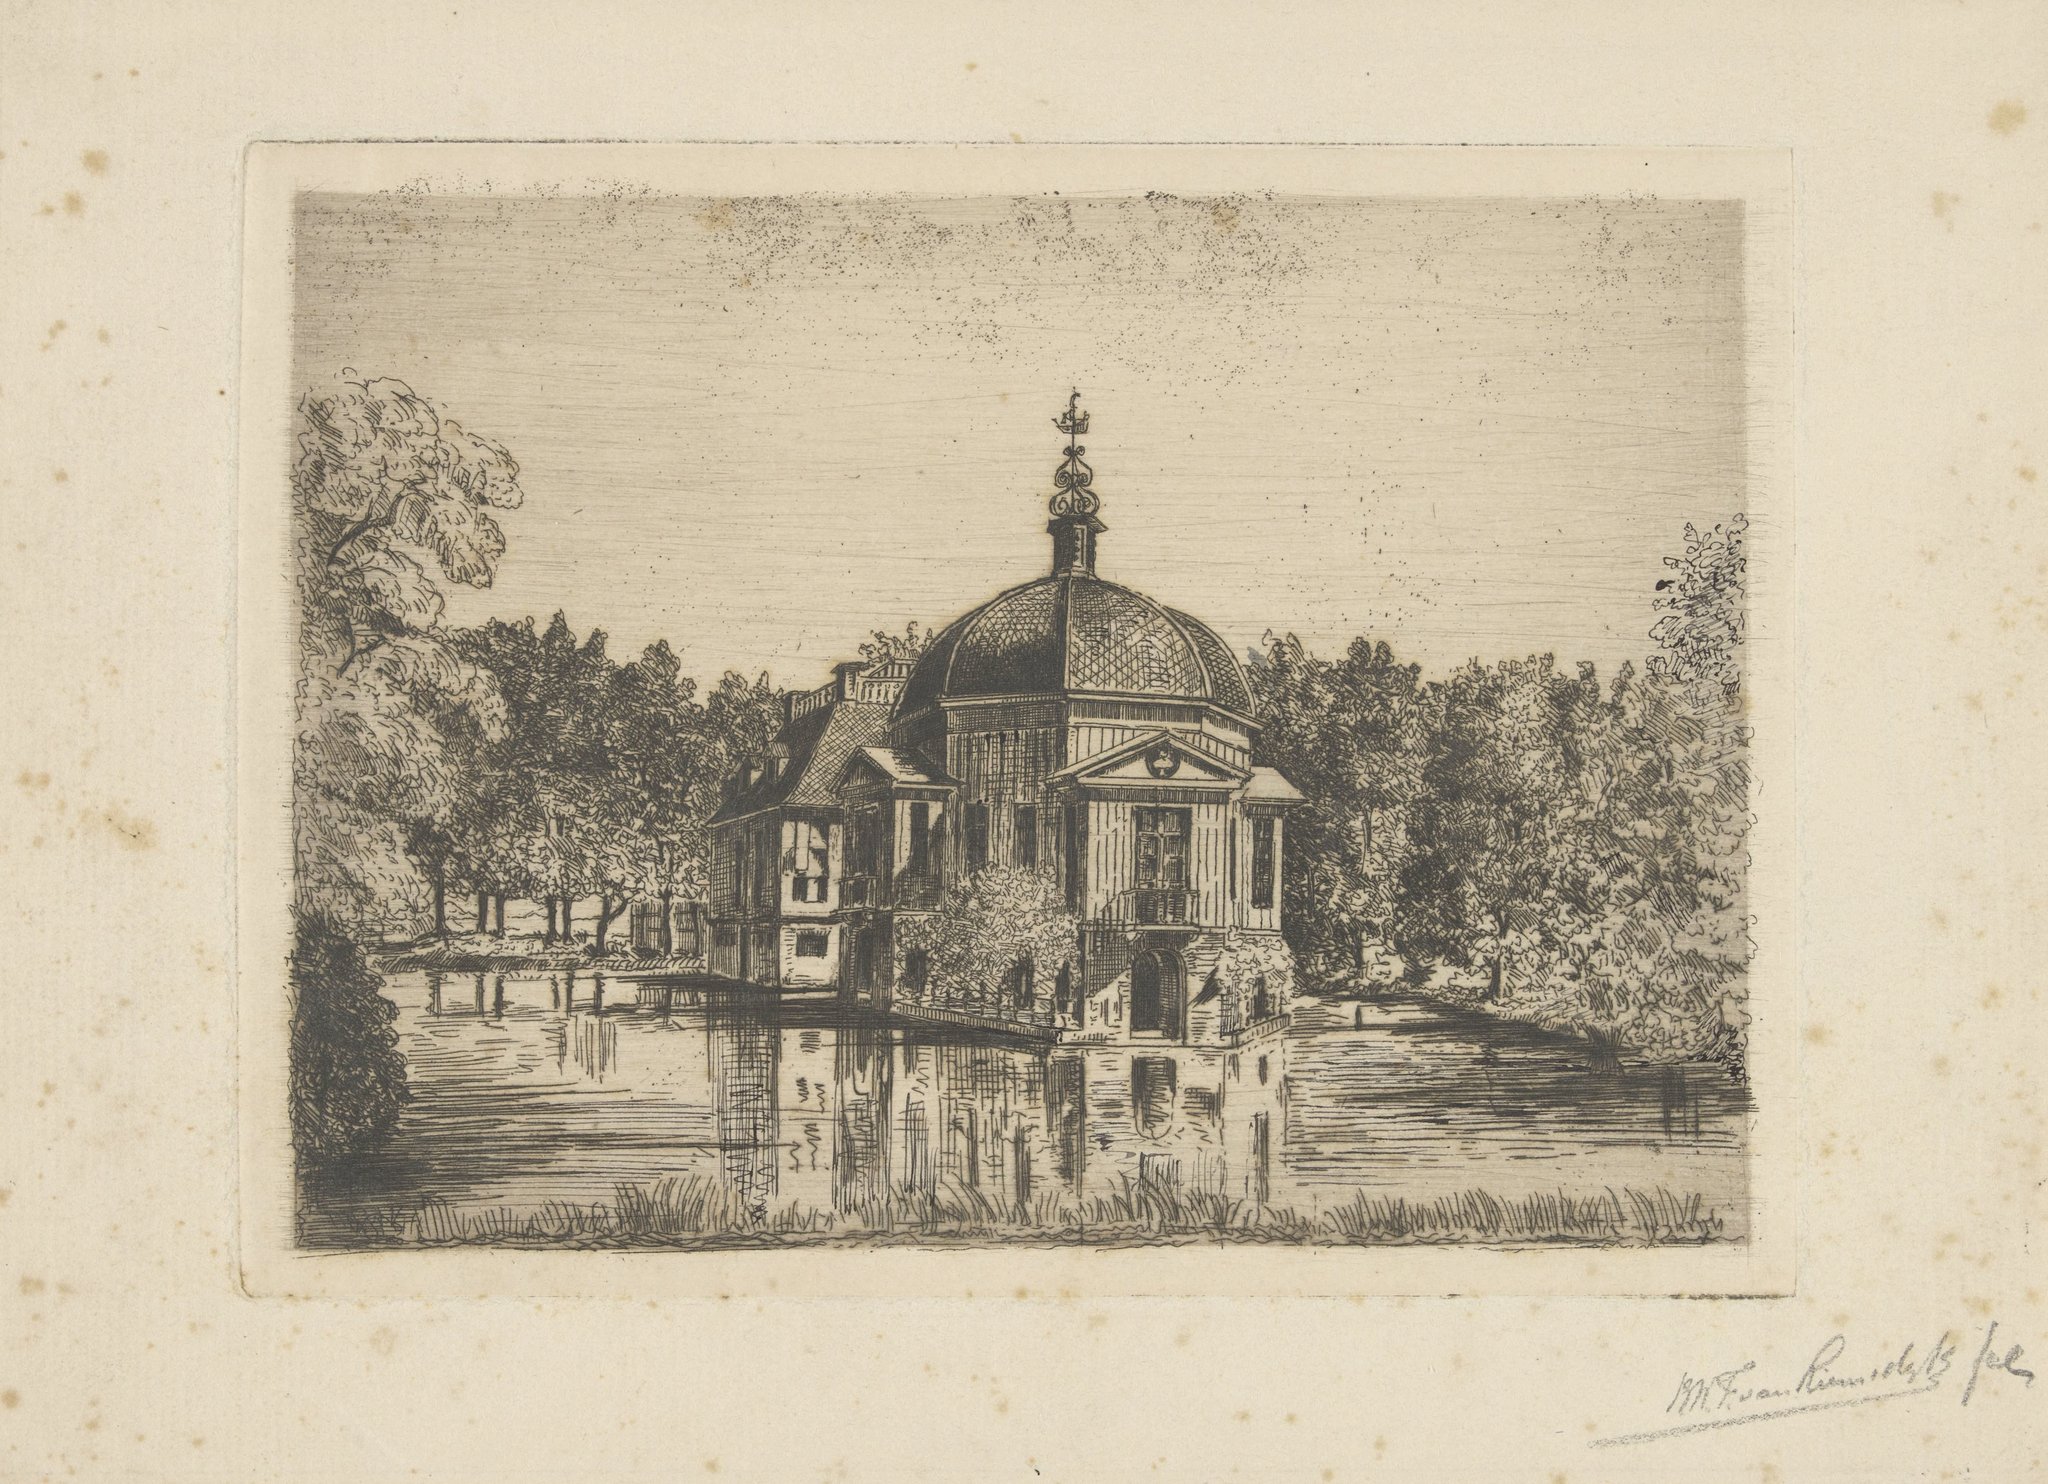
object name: print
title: Gezicht op Trompenburgh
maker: jonkheer barthold willem floris van riemsdijk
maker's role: engineer, print maker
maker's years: 1850-1942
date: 1896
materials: paper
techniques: drypoint, intaglio, pen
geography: netherlands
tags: country-house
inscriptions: inscription: ‘BWF van Riemsdijk fec’, collector's mark: Lugt 2228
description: Gezicht op de achterkant van landhuis Trompenburgh te 's-Graveland. De buitenplaats ligt in een vierkante vijver en is volledig door bomen omringd.